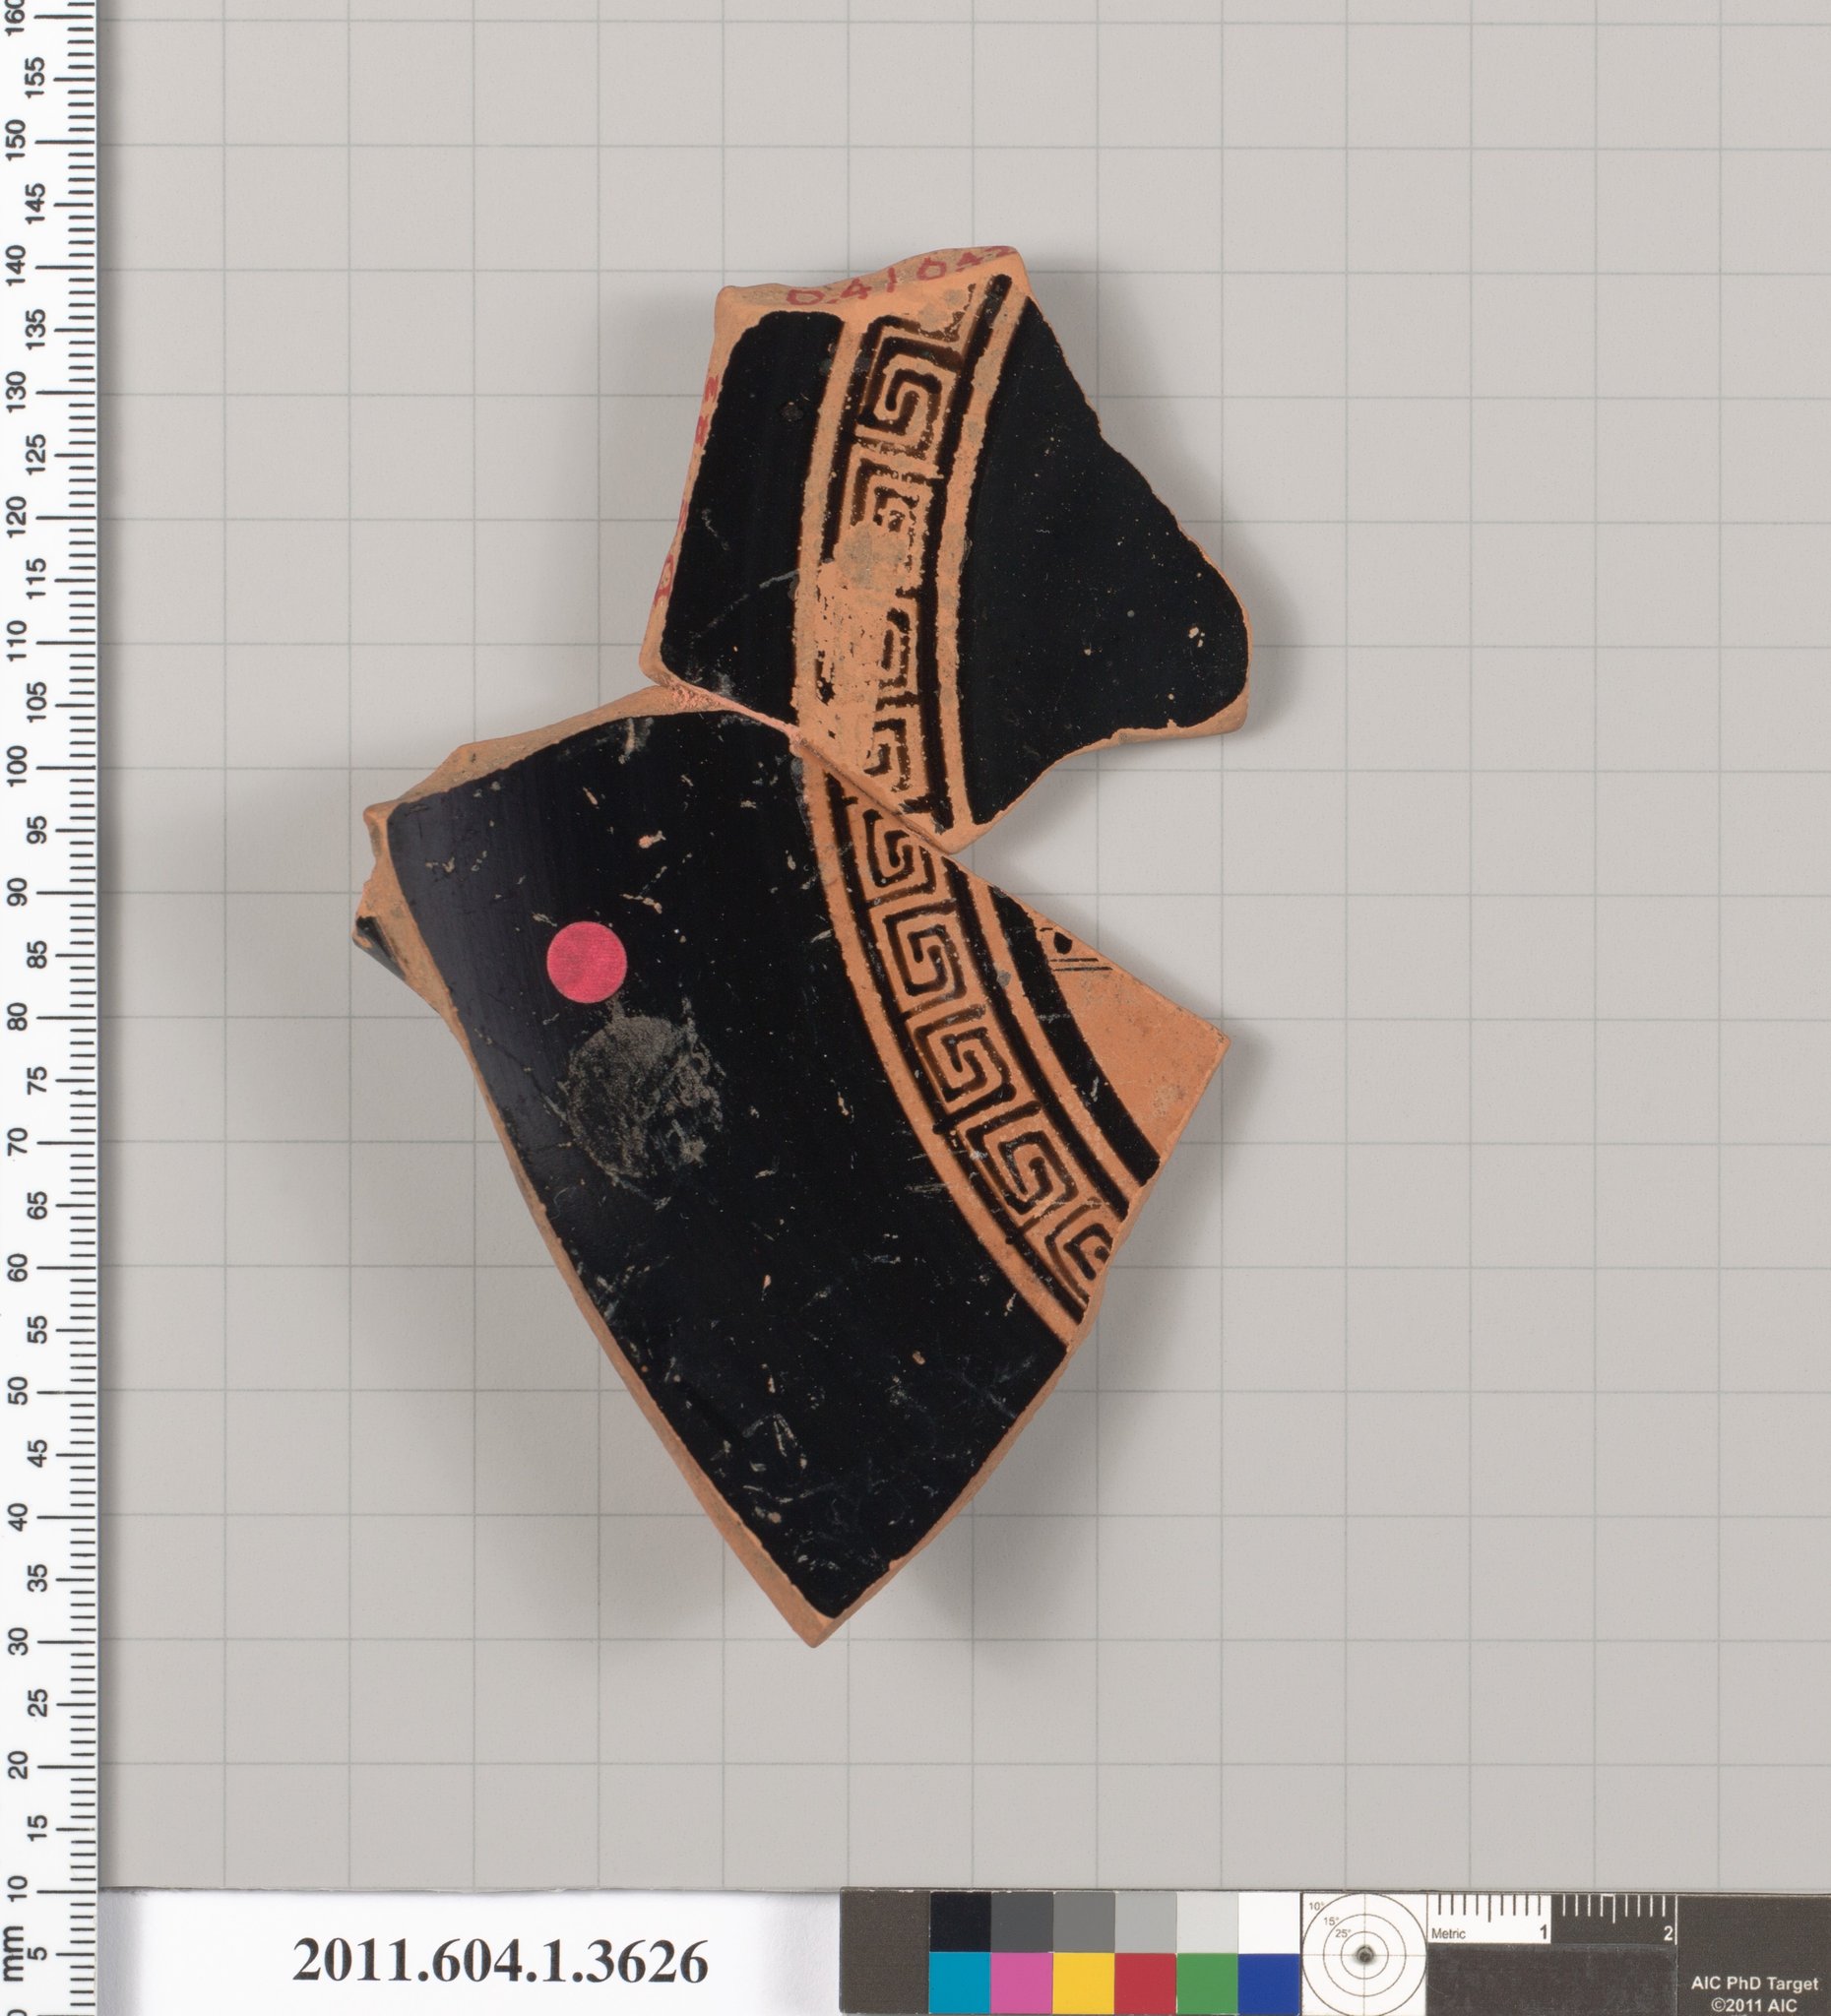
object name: kylix fragment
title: Terracotta fragment of a kylix (drinking cup)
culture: greek, attic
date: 490-470 BCE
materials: terracotta